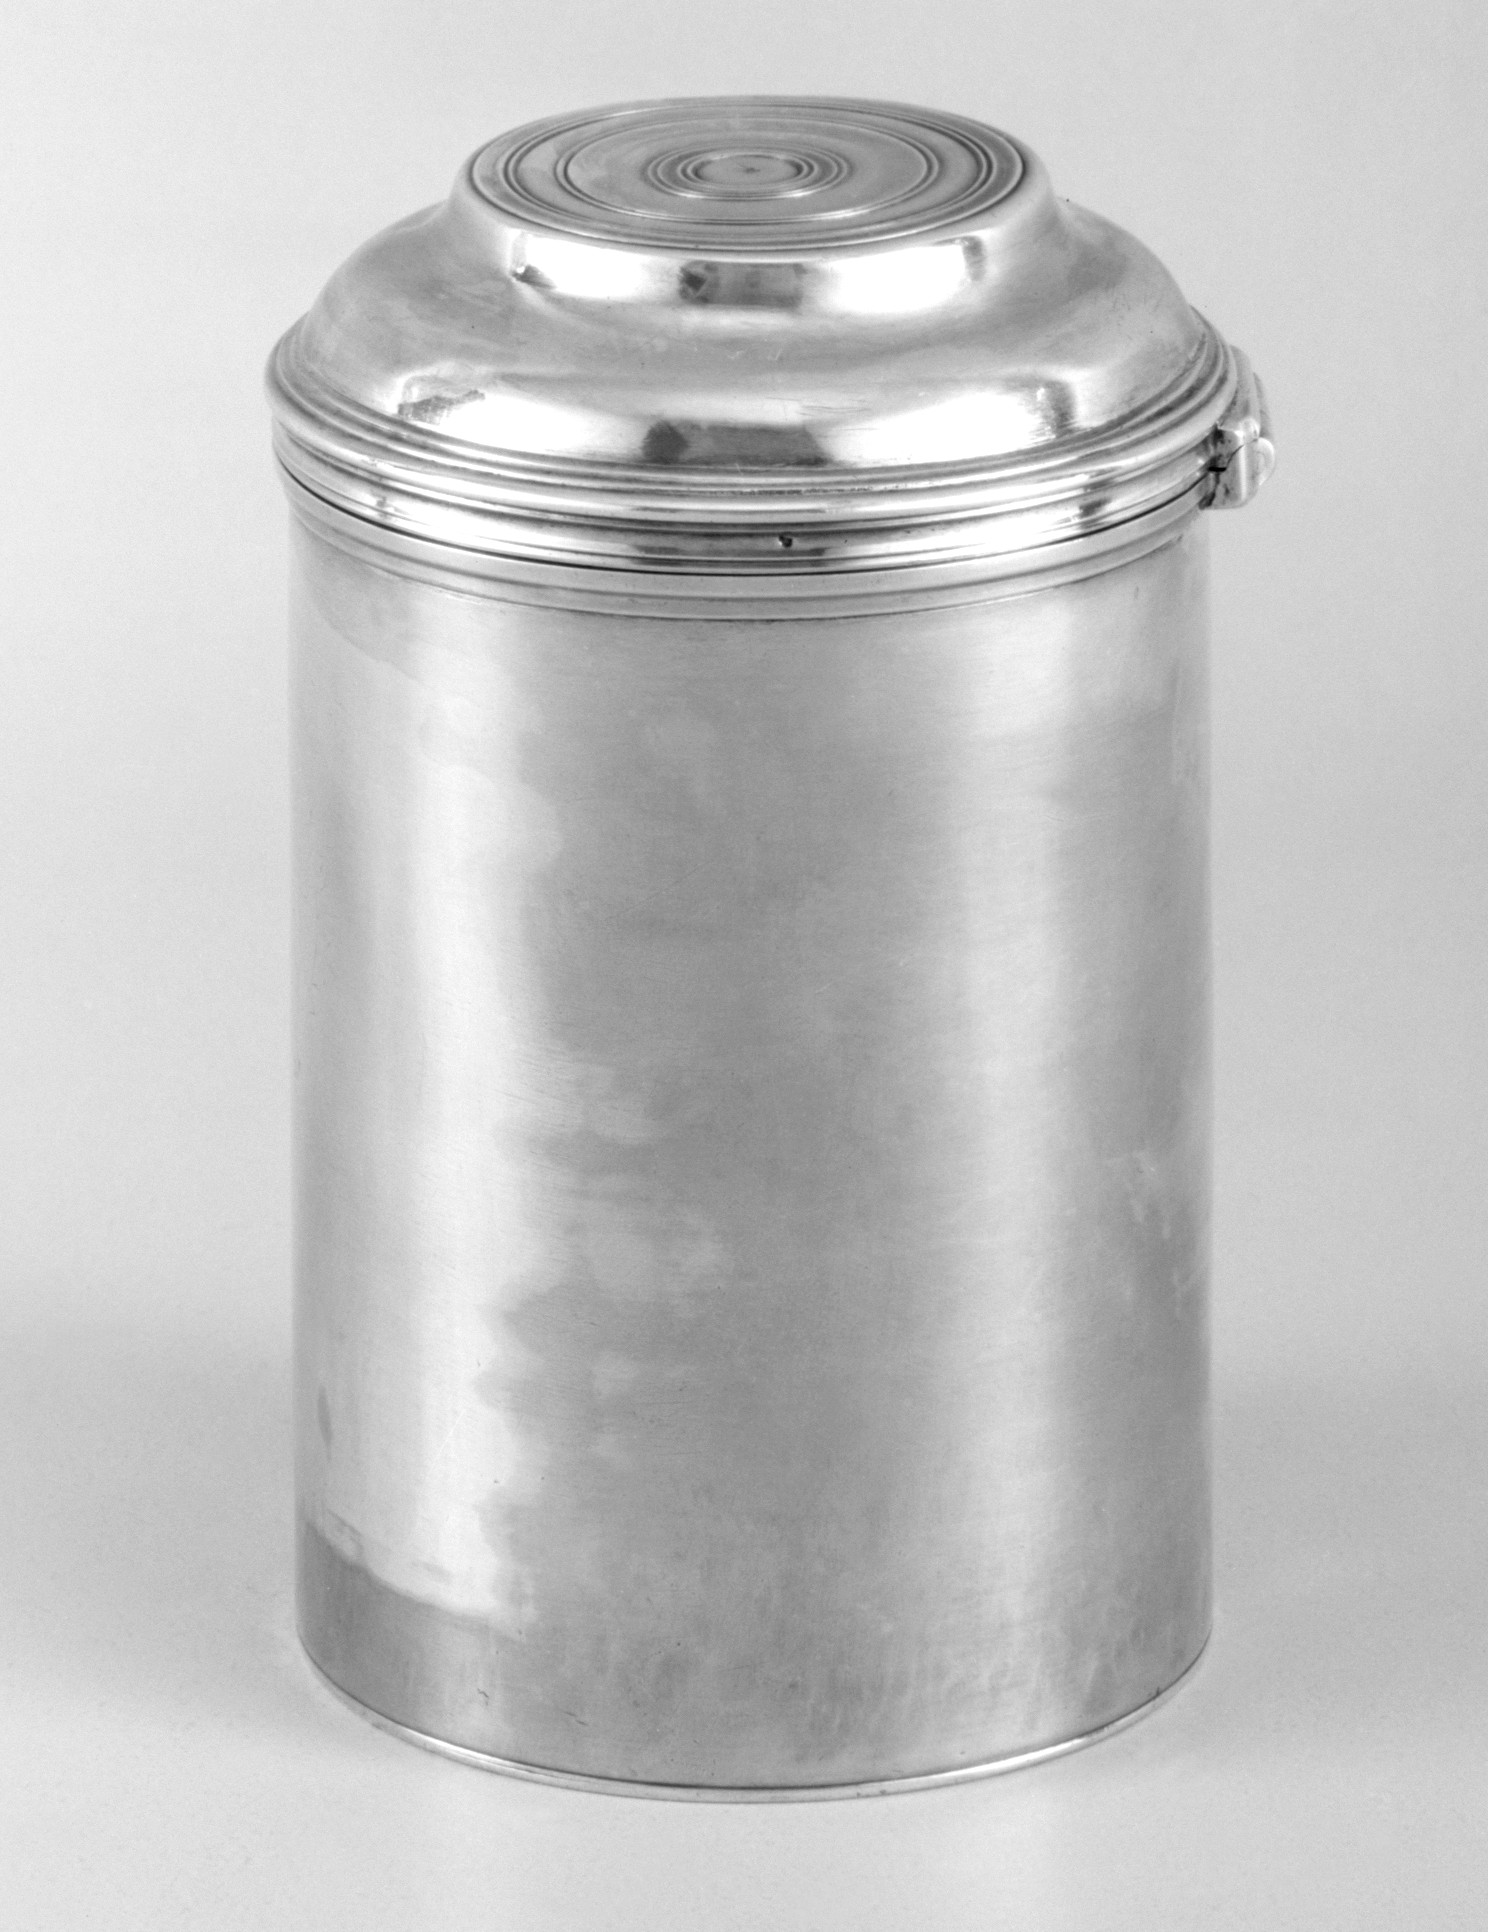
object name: jar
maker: claude dargent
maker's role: maker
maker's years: 1698-1798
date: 1739-1740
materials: silver